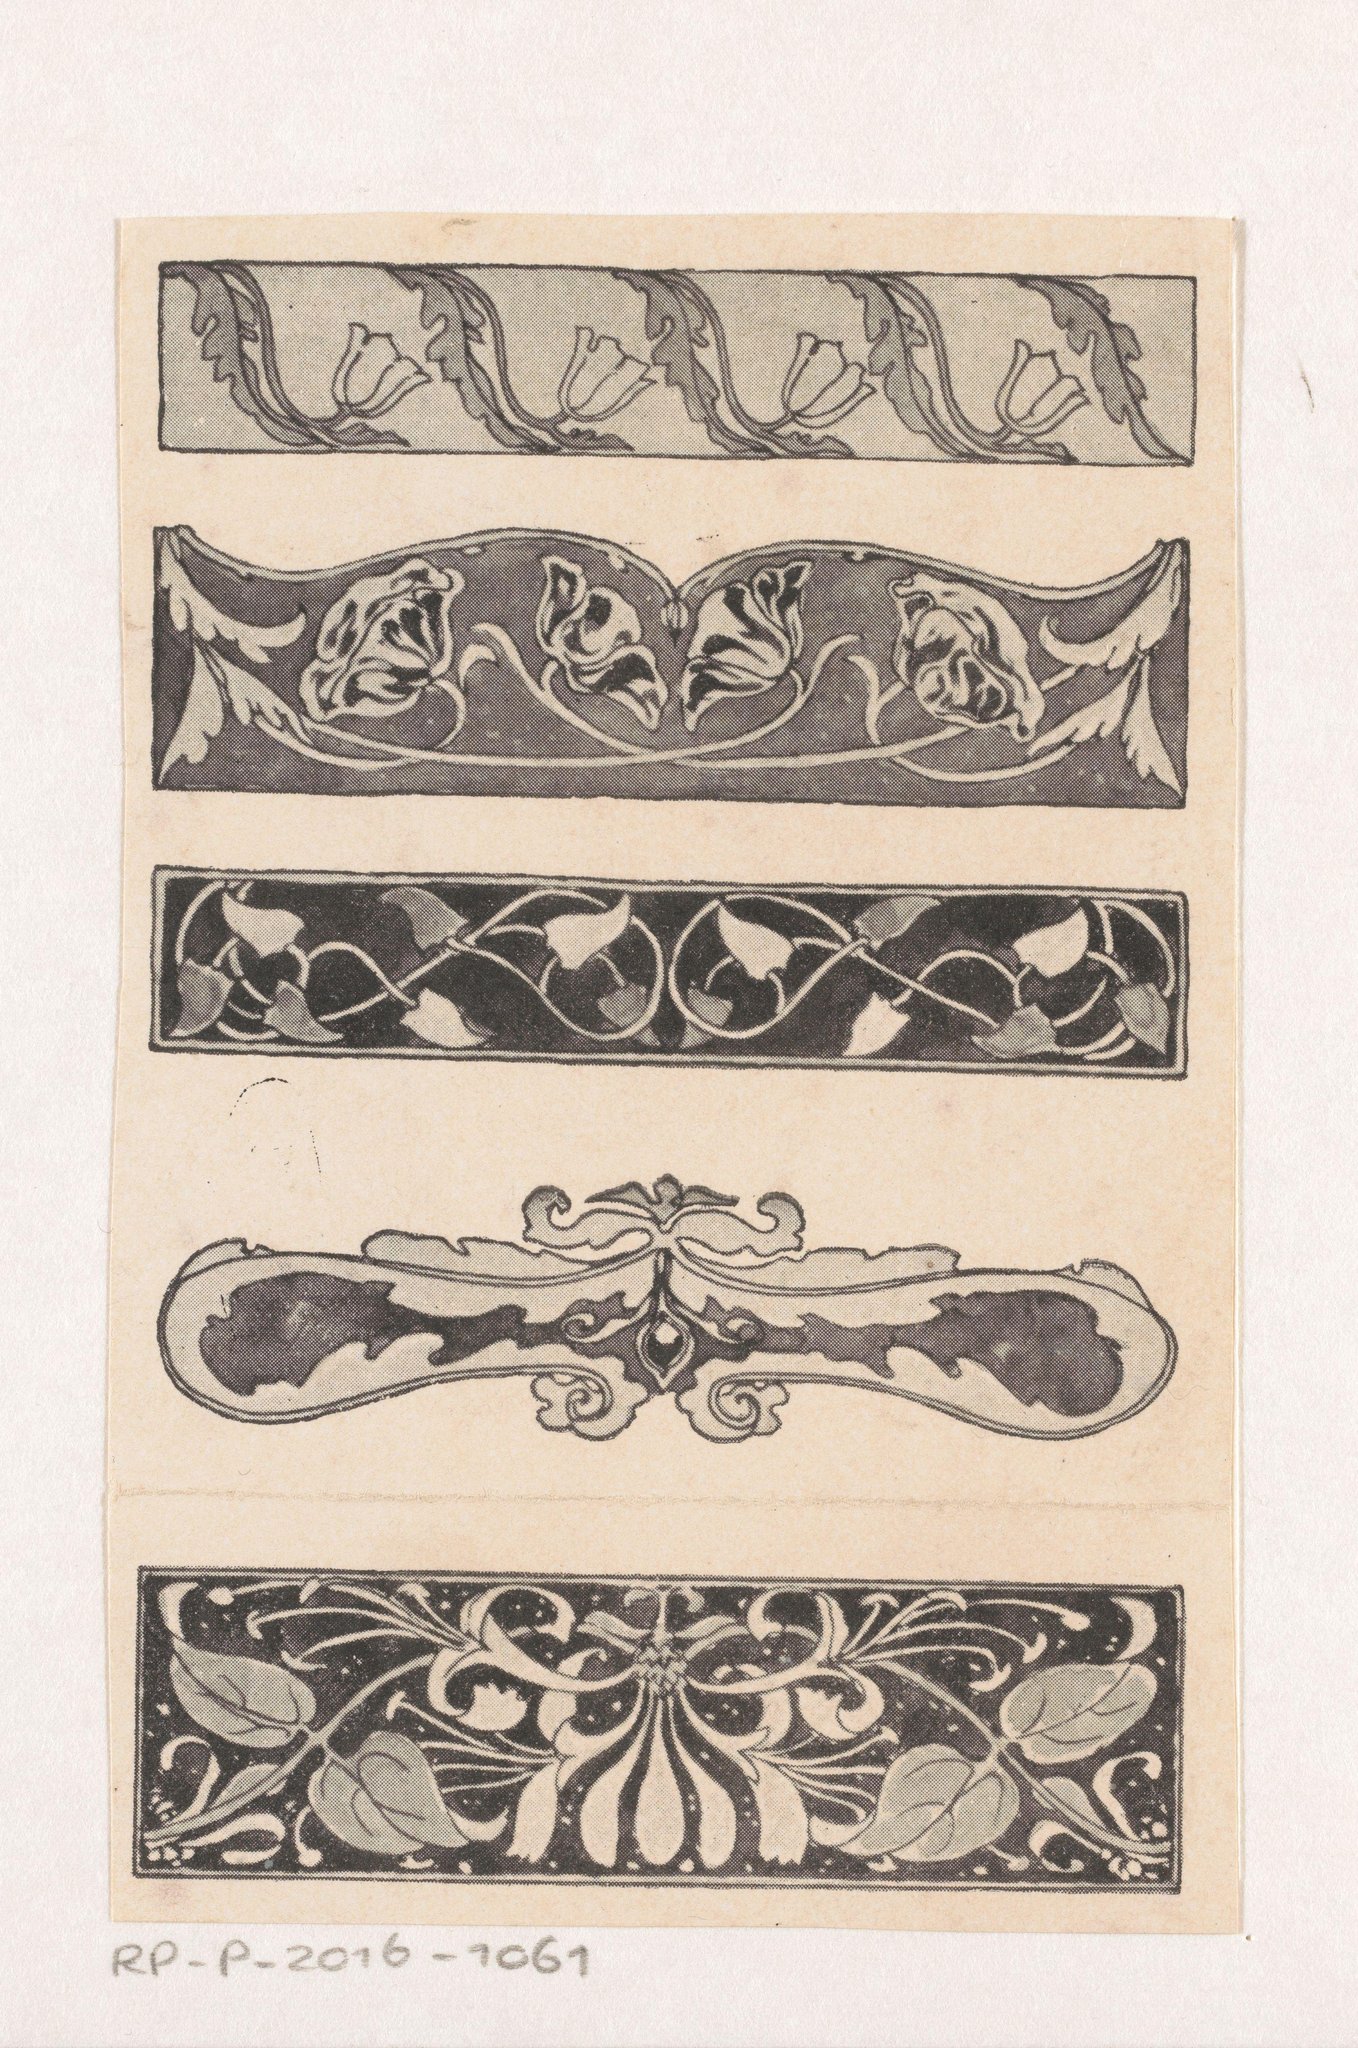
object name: photomechanical print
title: Ornamenten met bloemen en bladeren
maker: Anonymous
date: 1870-1937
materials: paper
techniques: printing block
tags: flowers ~ ornament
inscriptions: collector's mark: Lugt 2228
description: Vijf ontwerpen voor ornamenten met (gestileerde) bloemmotieven in de vorm van horizontale decoratieve banden.